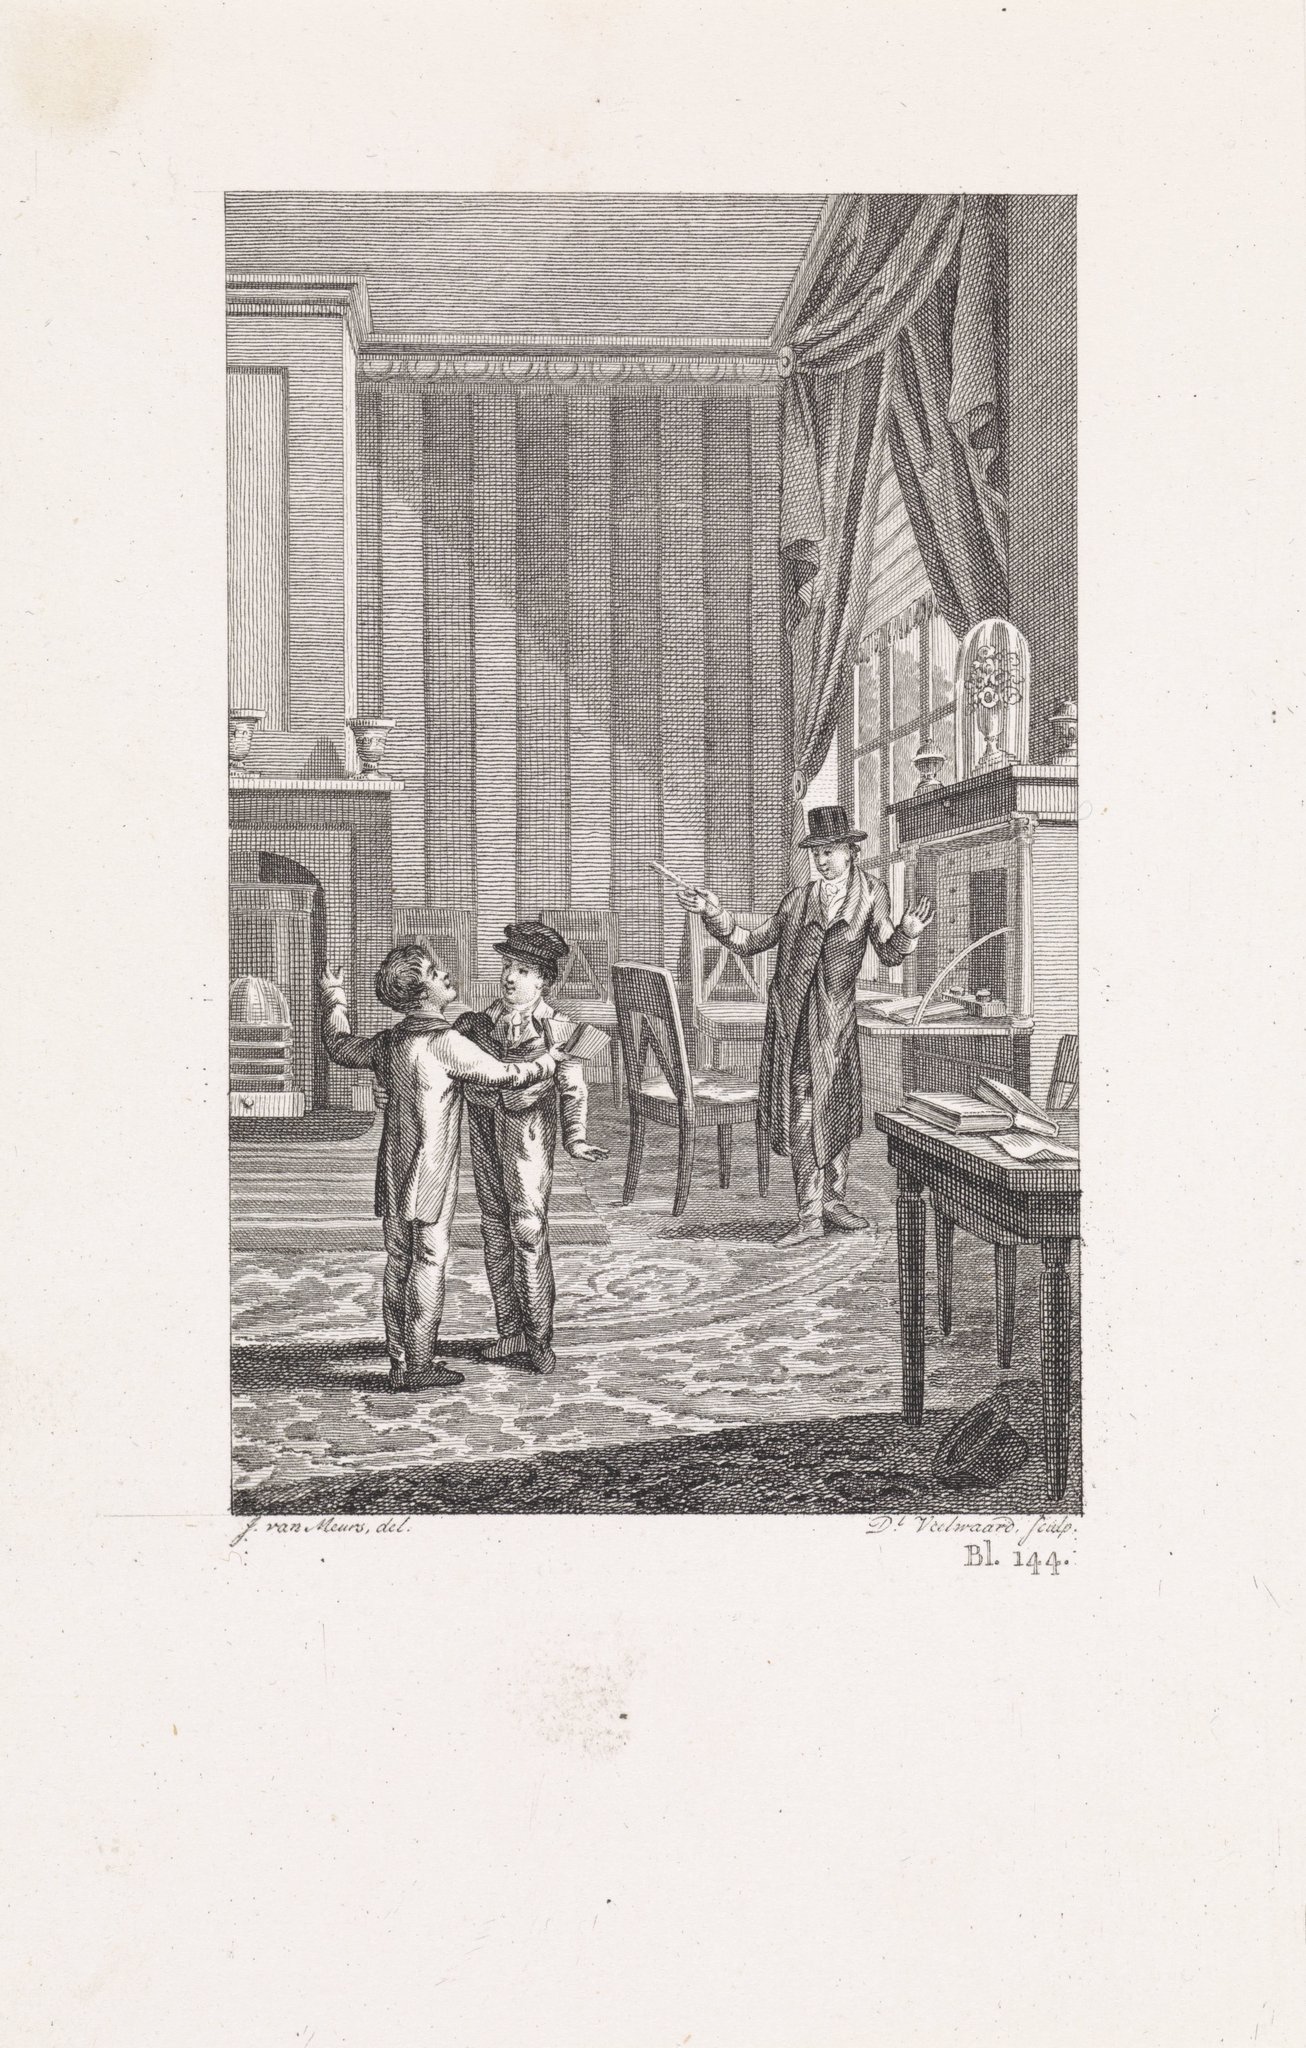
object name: print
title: Twee dansende jongens in een interieur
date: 1776-1815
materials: paper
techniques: etching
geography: amsterdam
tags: dancing, baton ~ conductor, interior of the house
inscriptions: collector's mark: Lugt 2228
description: Twee dansende jongens in een interieur. Op de achtergrond speelt een man met een hoge hoed voor dirigent. Rechtsonder: Bl. 144.